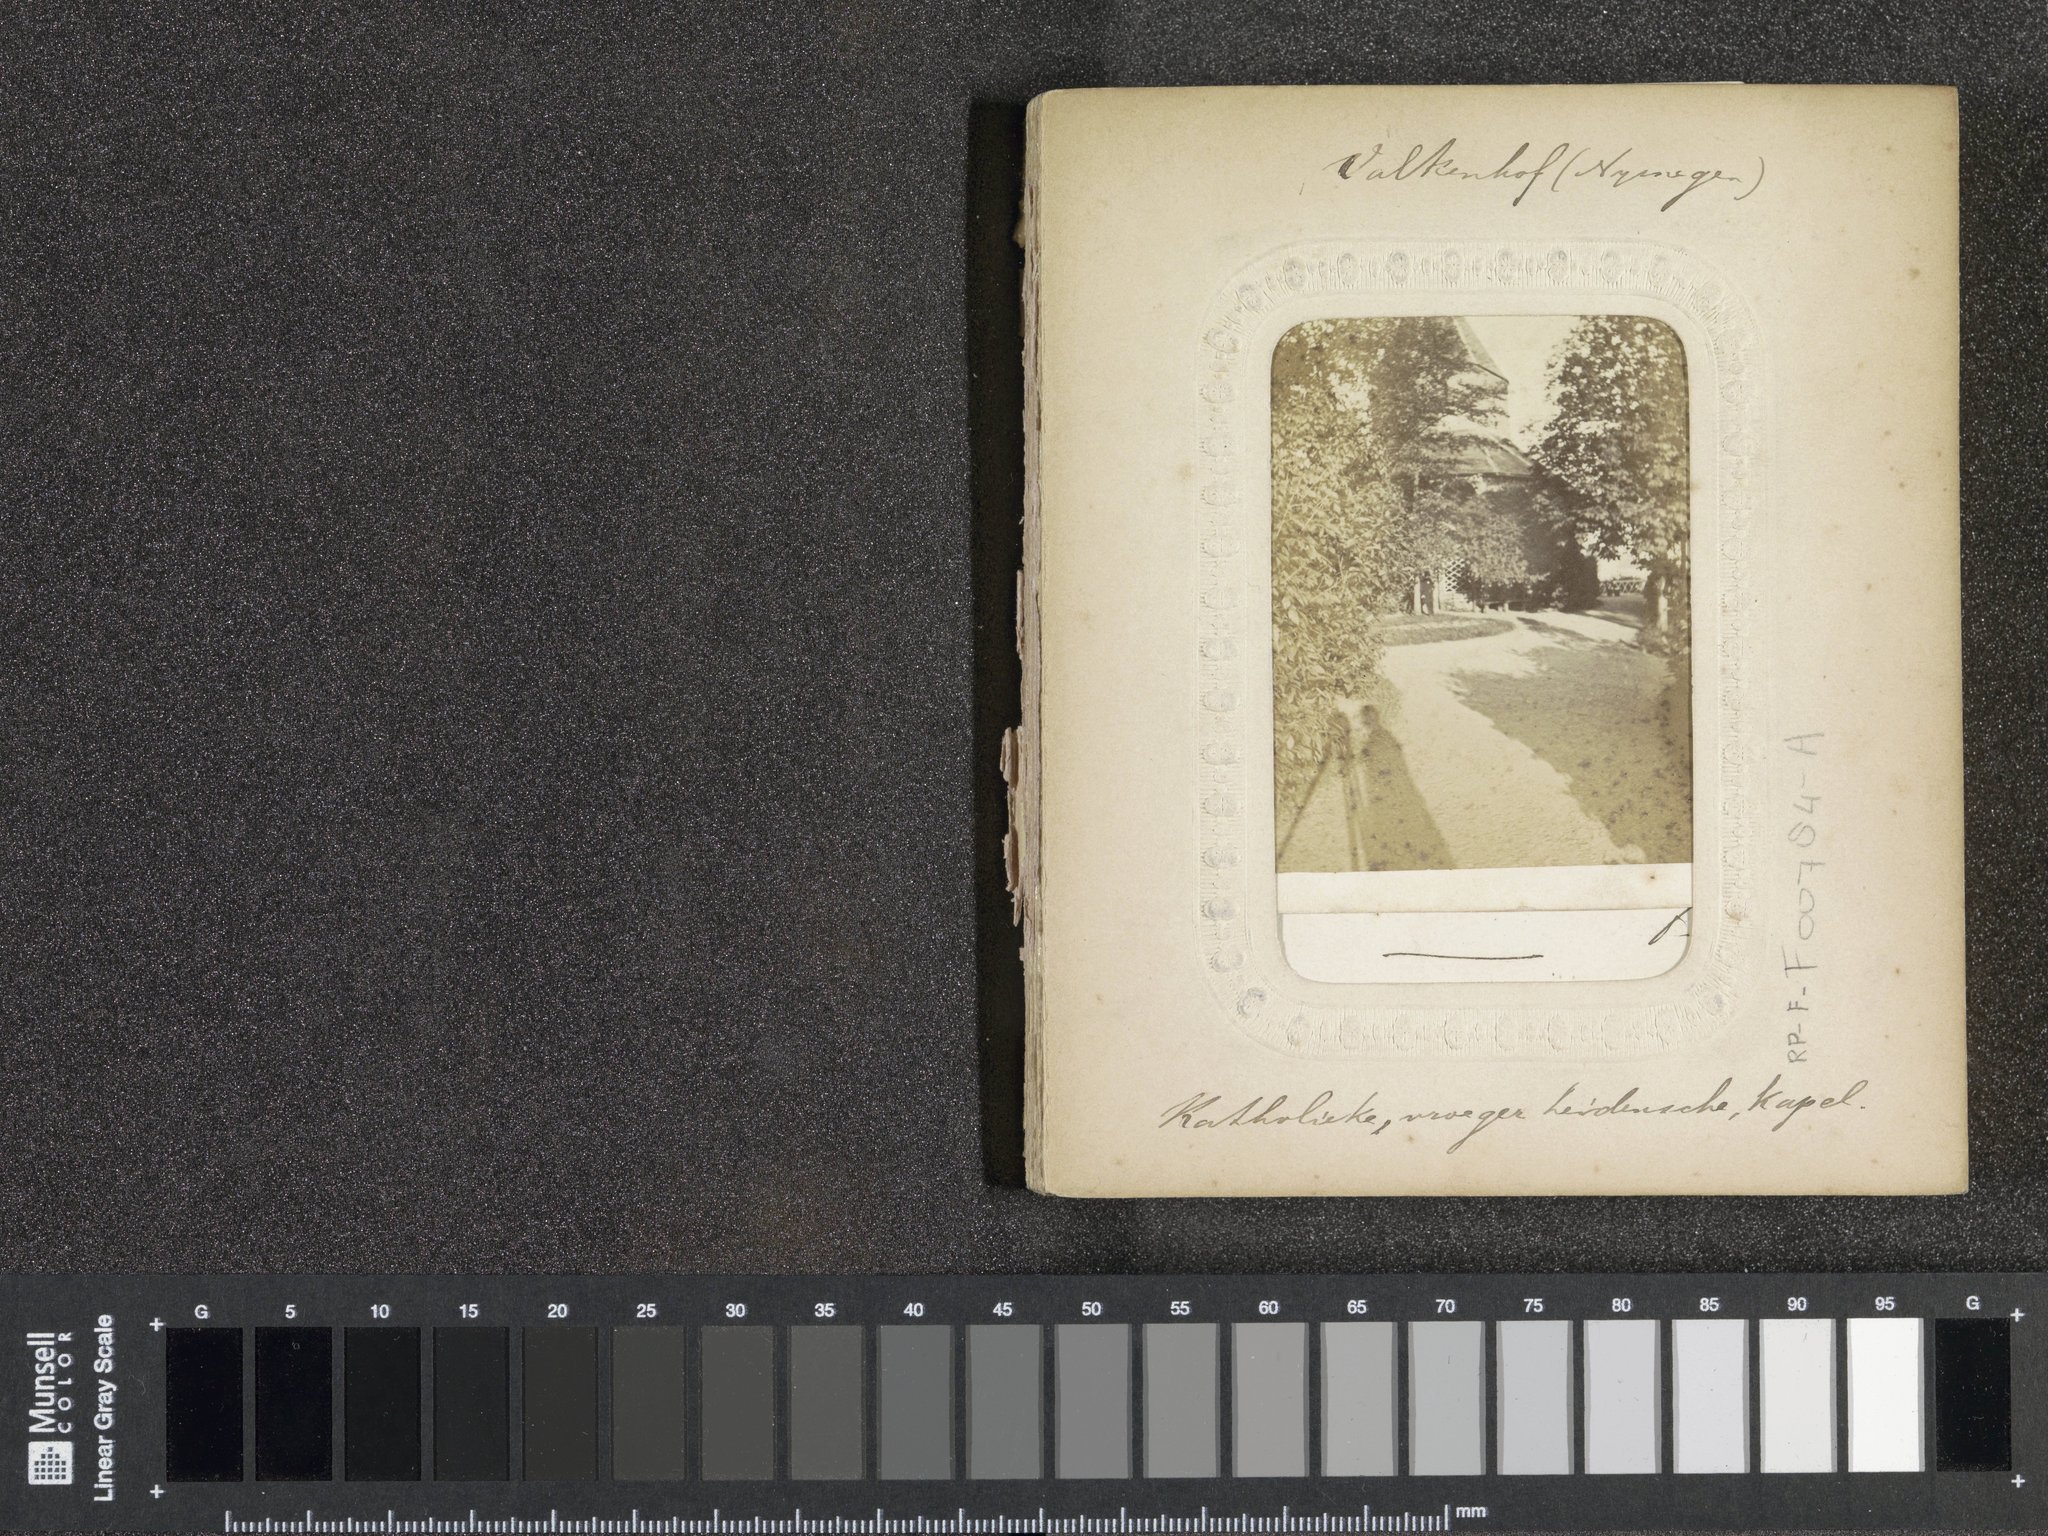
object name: photograph album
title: Fotoalbum met bezienswaardigheden in Nederlandse, Belgische en Duitse steden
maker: Anonymous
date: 1868-1872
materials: cardboard, paper, photographic support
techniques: albumen print, lithograph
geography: western europe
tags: travelling; tourism, prospect of city, town panorama, silhouette of city, netherlands, germany, belgium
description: Fotoalbum waarvan de band ontbreekt. Het boekblok bestaat uit 12 bladen goud op snee met 24 cartes-de-visite in passe-partouts. Mogelijk heeft het album ooit meerdere bladen gehad, gelet op het afgebroken jaartal op de laatste pagina. De foto's hebben boven en onder hun passe-partouts handgeschreven bijschriften; op de achterzijde van de cartes-de-visite is vaak (nagenoeg) dezelfde tekst vermeld. Naast de foto zijn jaartallen genoteerd, lopend van 1868 tot en met 1872. Het betreft voornamelijk opnames van gebouwen zoals kerken, stadhuizen, poorten, paleizen van justitie en van parken in Nederland, Duitsland en België. Mogelijk was de samensteller ene Egbert de Vries, zijn naam of initialen staan herhaalde malen op de achterzijde van de cartes-de-visite genoteerd.